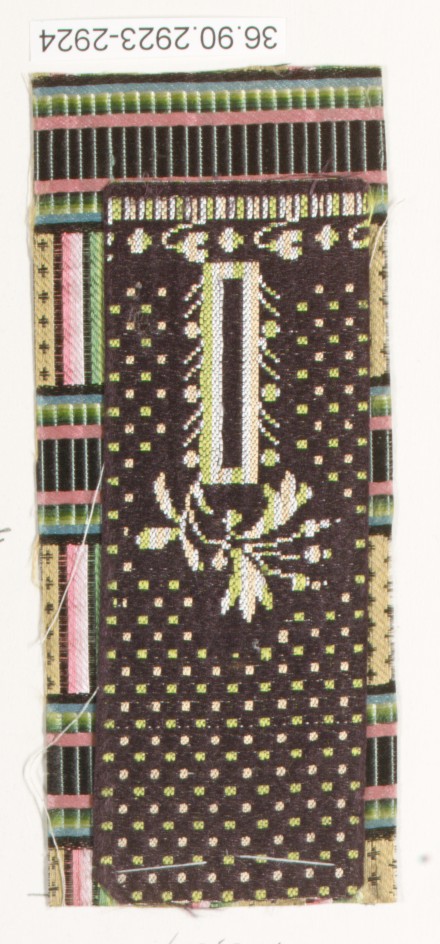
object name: piece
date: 1801-1900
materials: silk